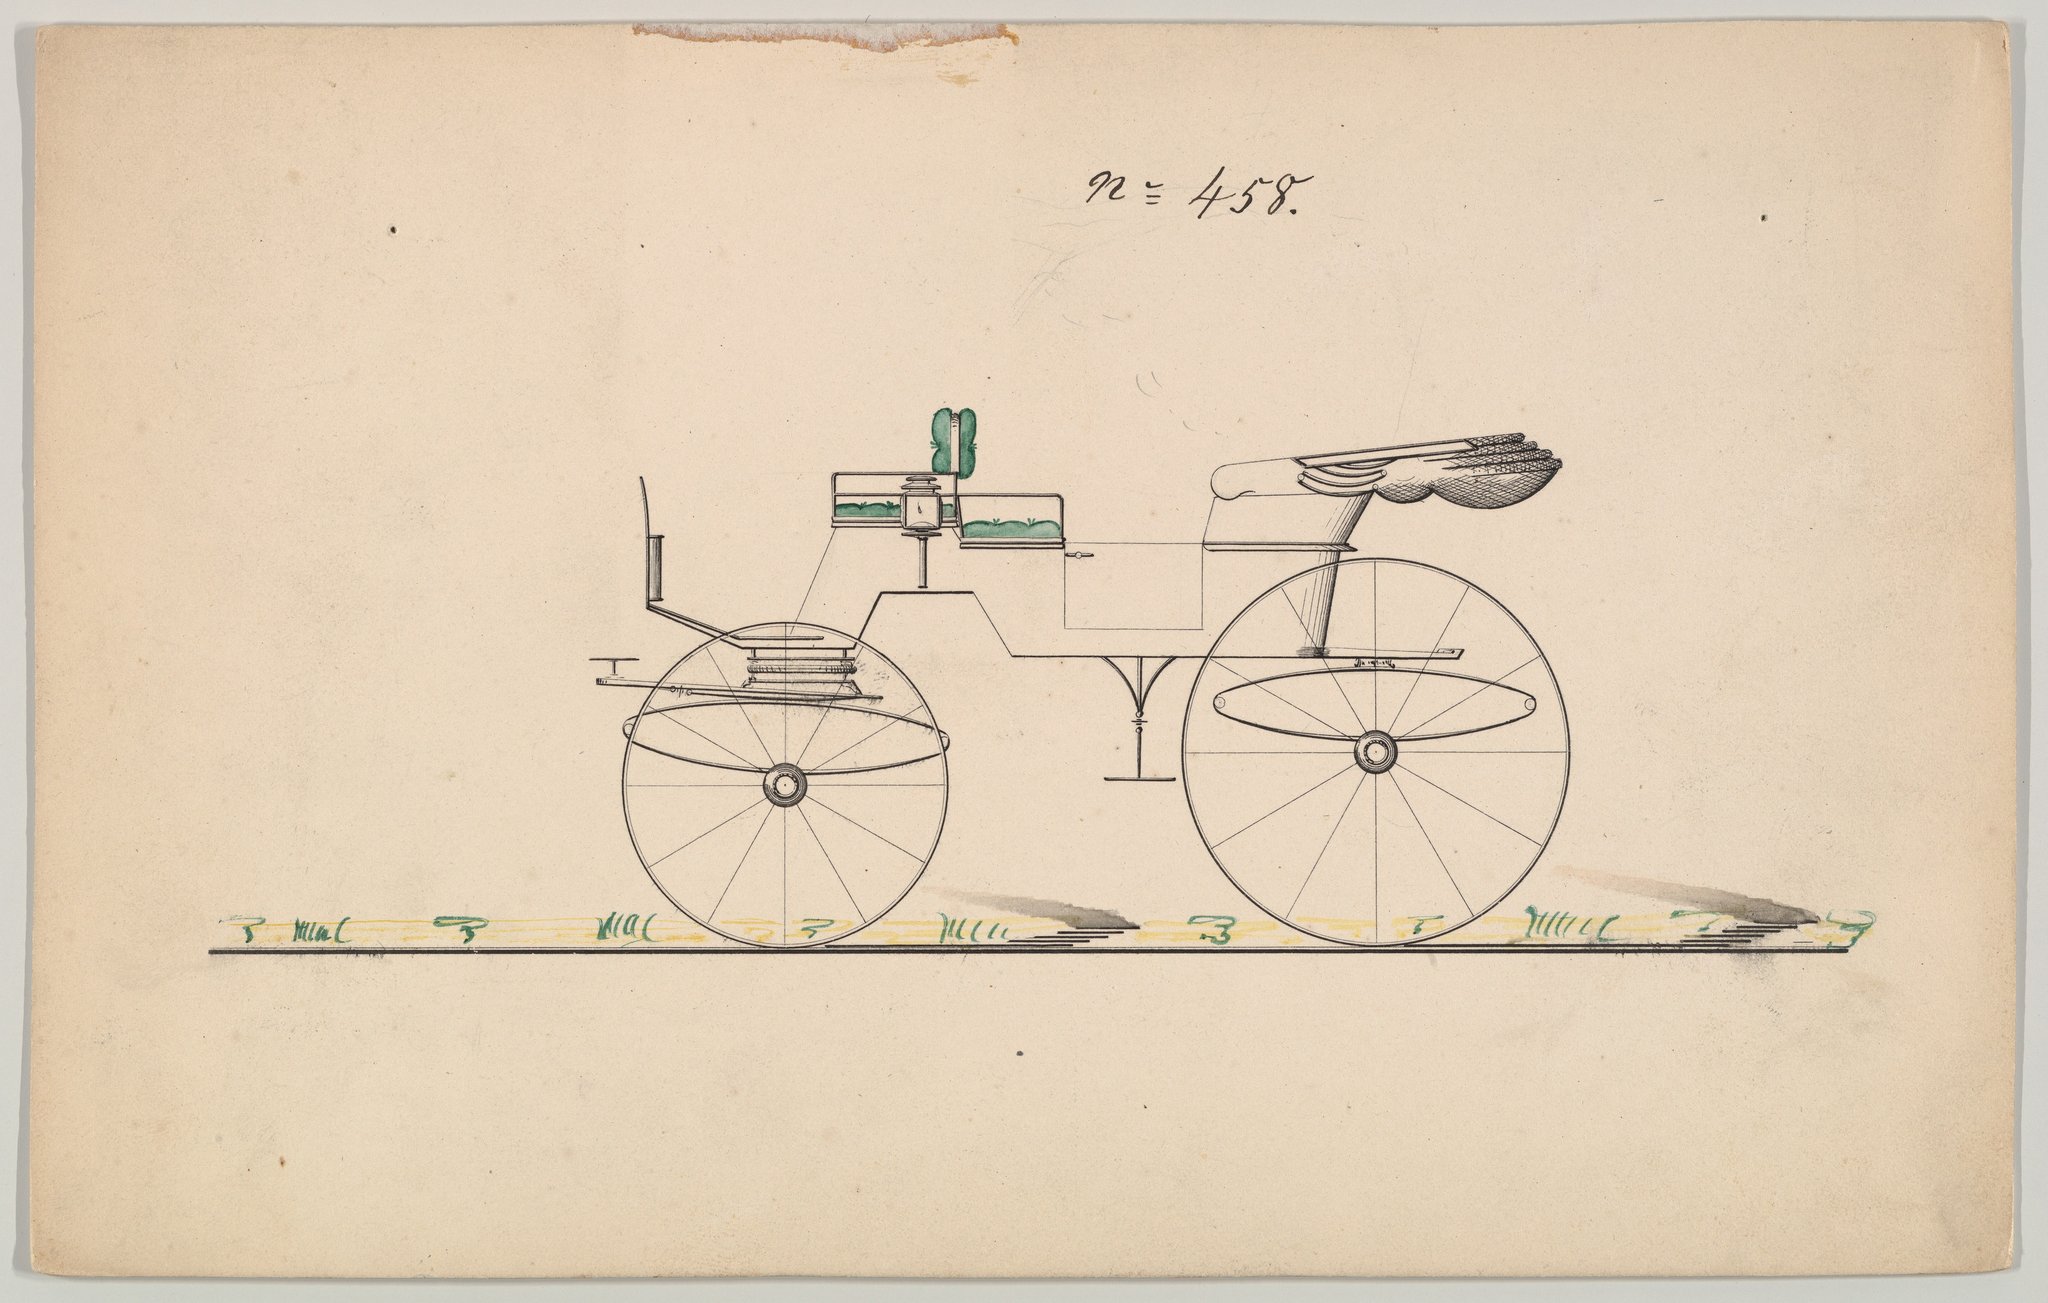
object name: drawing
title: Design for Vis-à-vis, no. 458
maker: brewster & co.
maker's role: manufacturer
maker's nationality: american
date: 1850-1870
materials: gouache, ink, watercolor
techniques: pen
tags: carriages